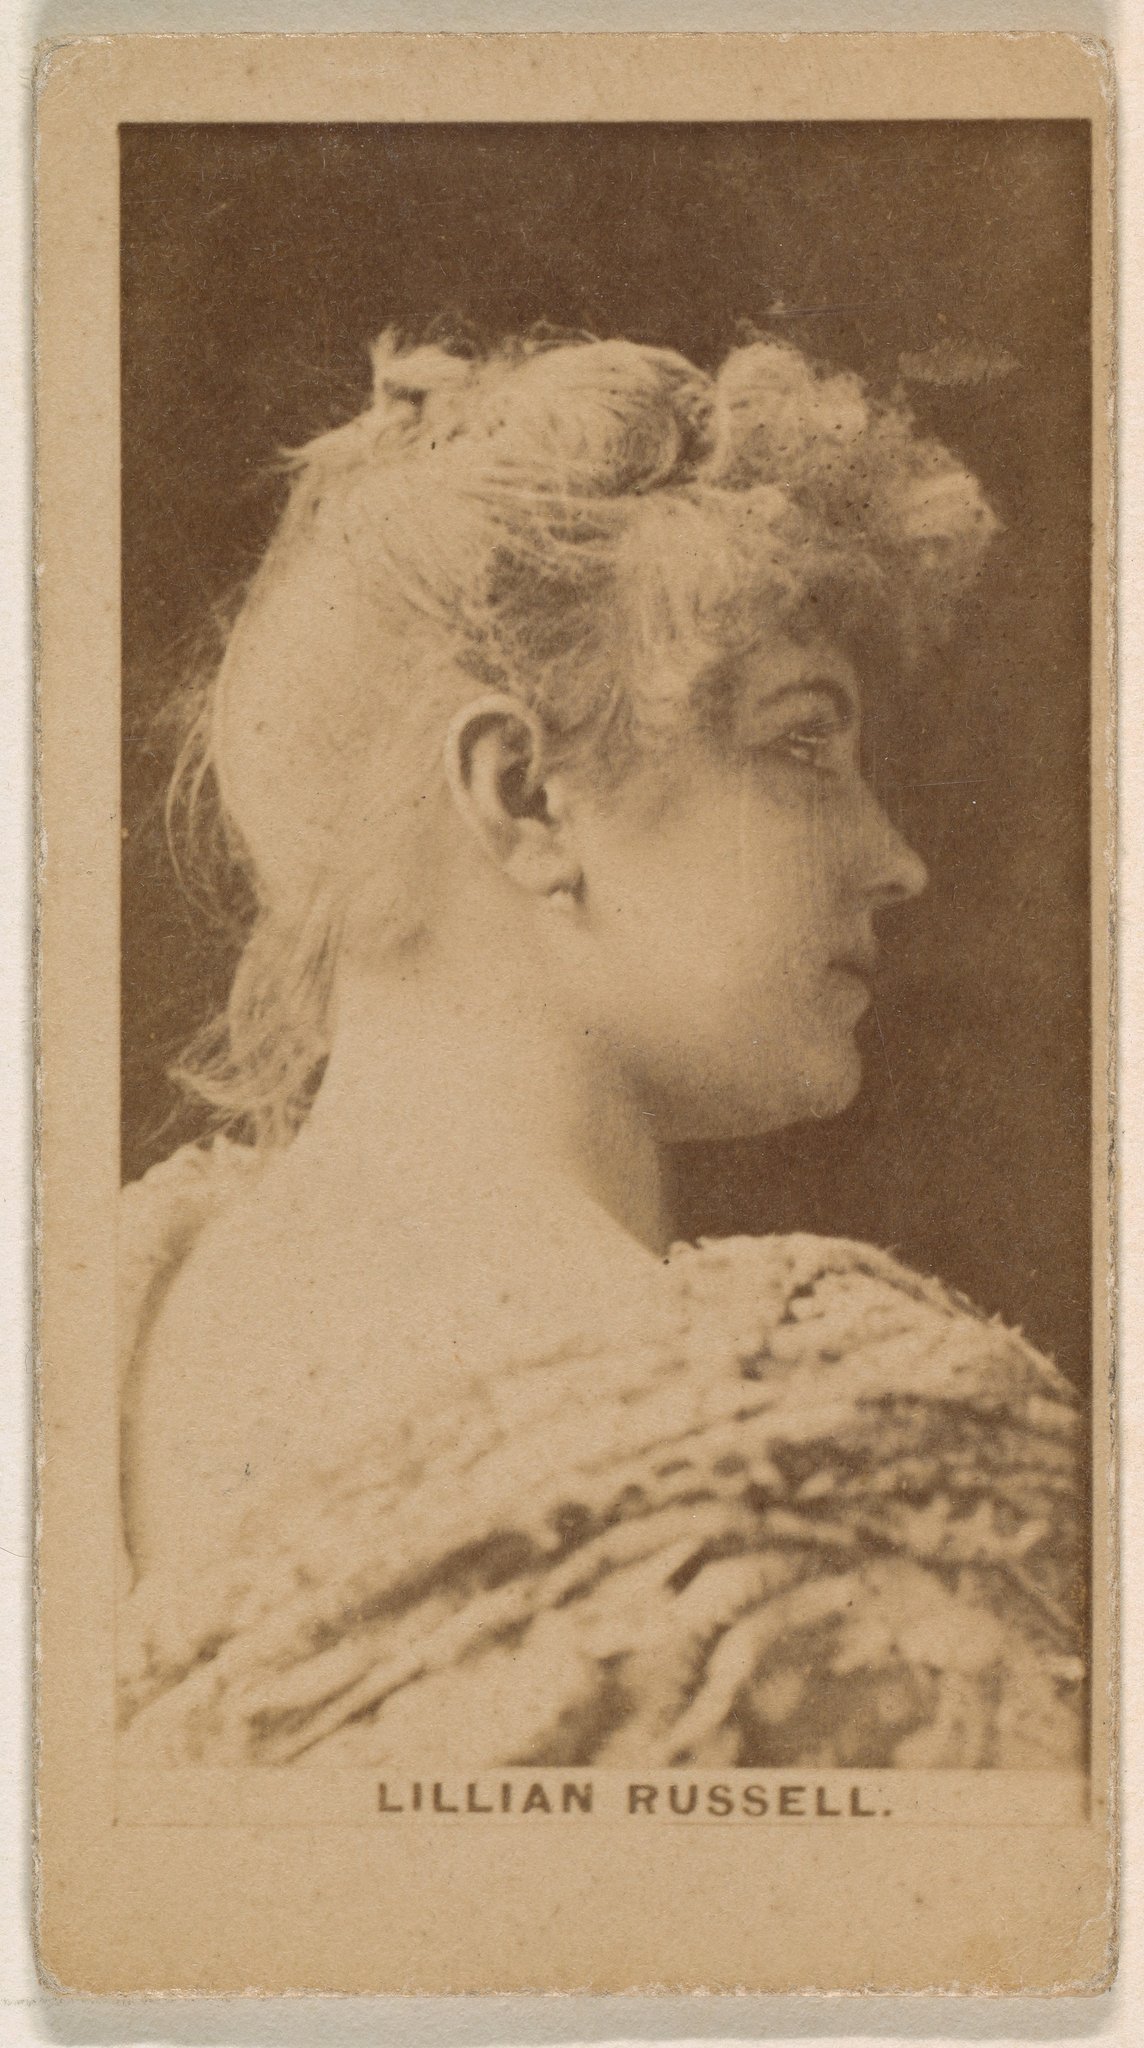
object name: photograph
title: Lillian Russell, from the Actresses series (N245) issued by Kinney Brothers to promote Sweet Caporal Cigarettes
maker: kinney brothers tobacco company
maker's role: publisher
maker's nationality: american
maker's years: 1869-2011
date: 1890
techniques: albumen silver print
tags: women,actresses